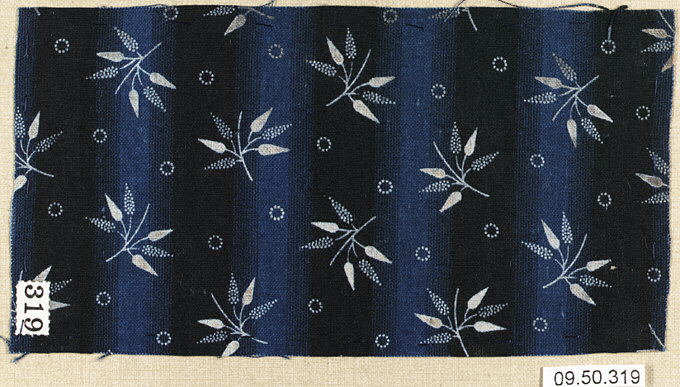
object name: piece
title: Piece (one of 116)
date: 1801-1900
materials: cotton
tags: leaves